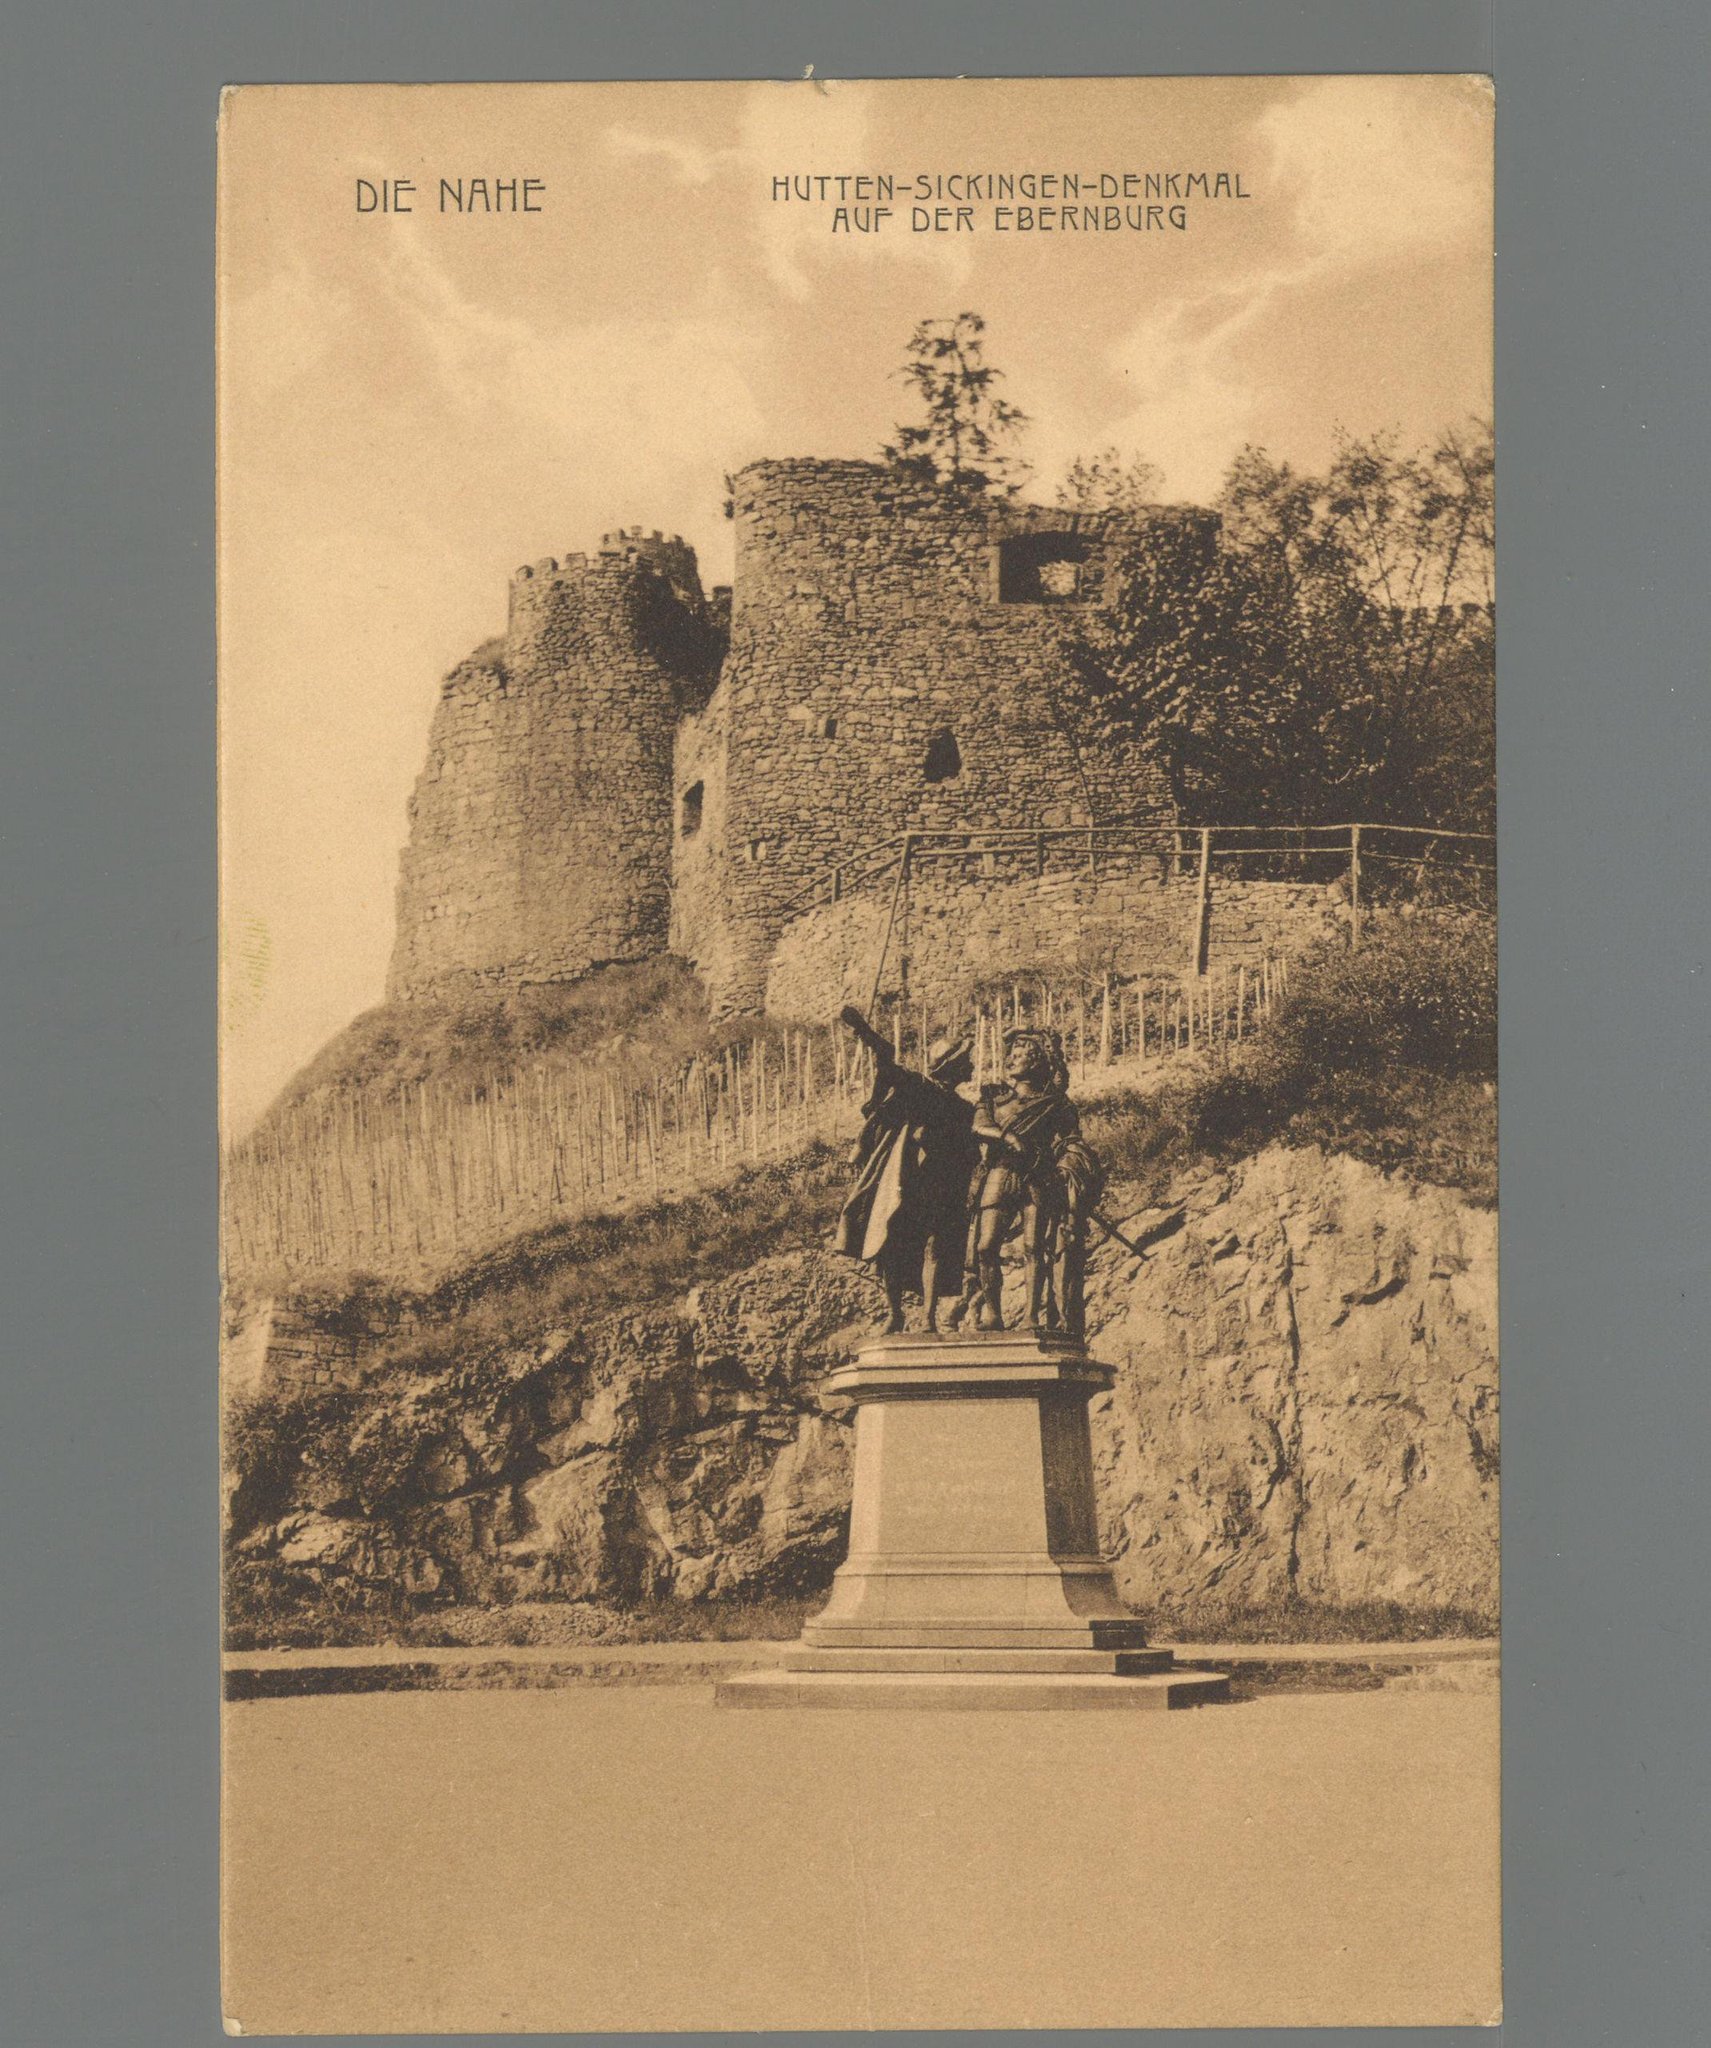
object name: photomechanical print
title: Die Nahe. Hutten-Sickingen-Denkmal auf der Ebernburg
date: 1907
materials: cardboard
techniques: photograph, writing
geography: mainz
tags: castle, monument, statue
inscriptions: date